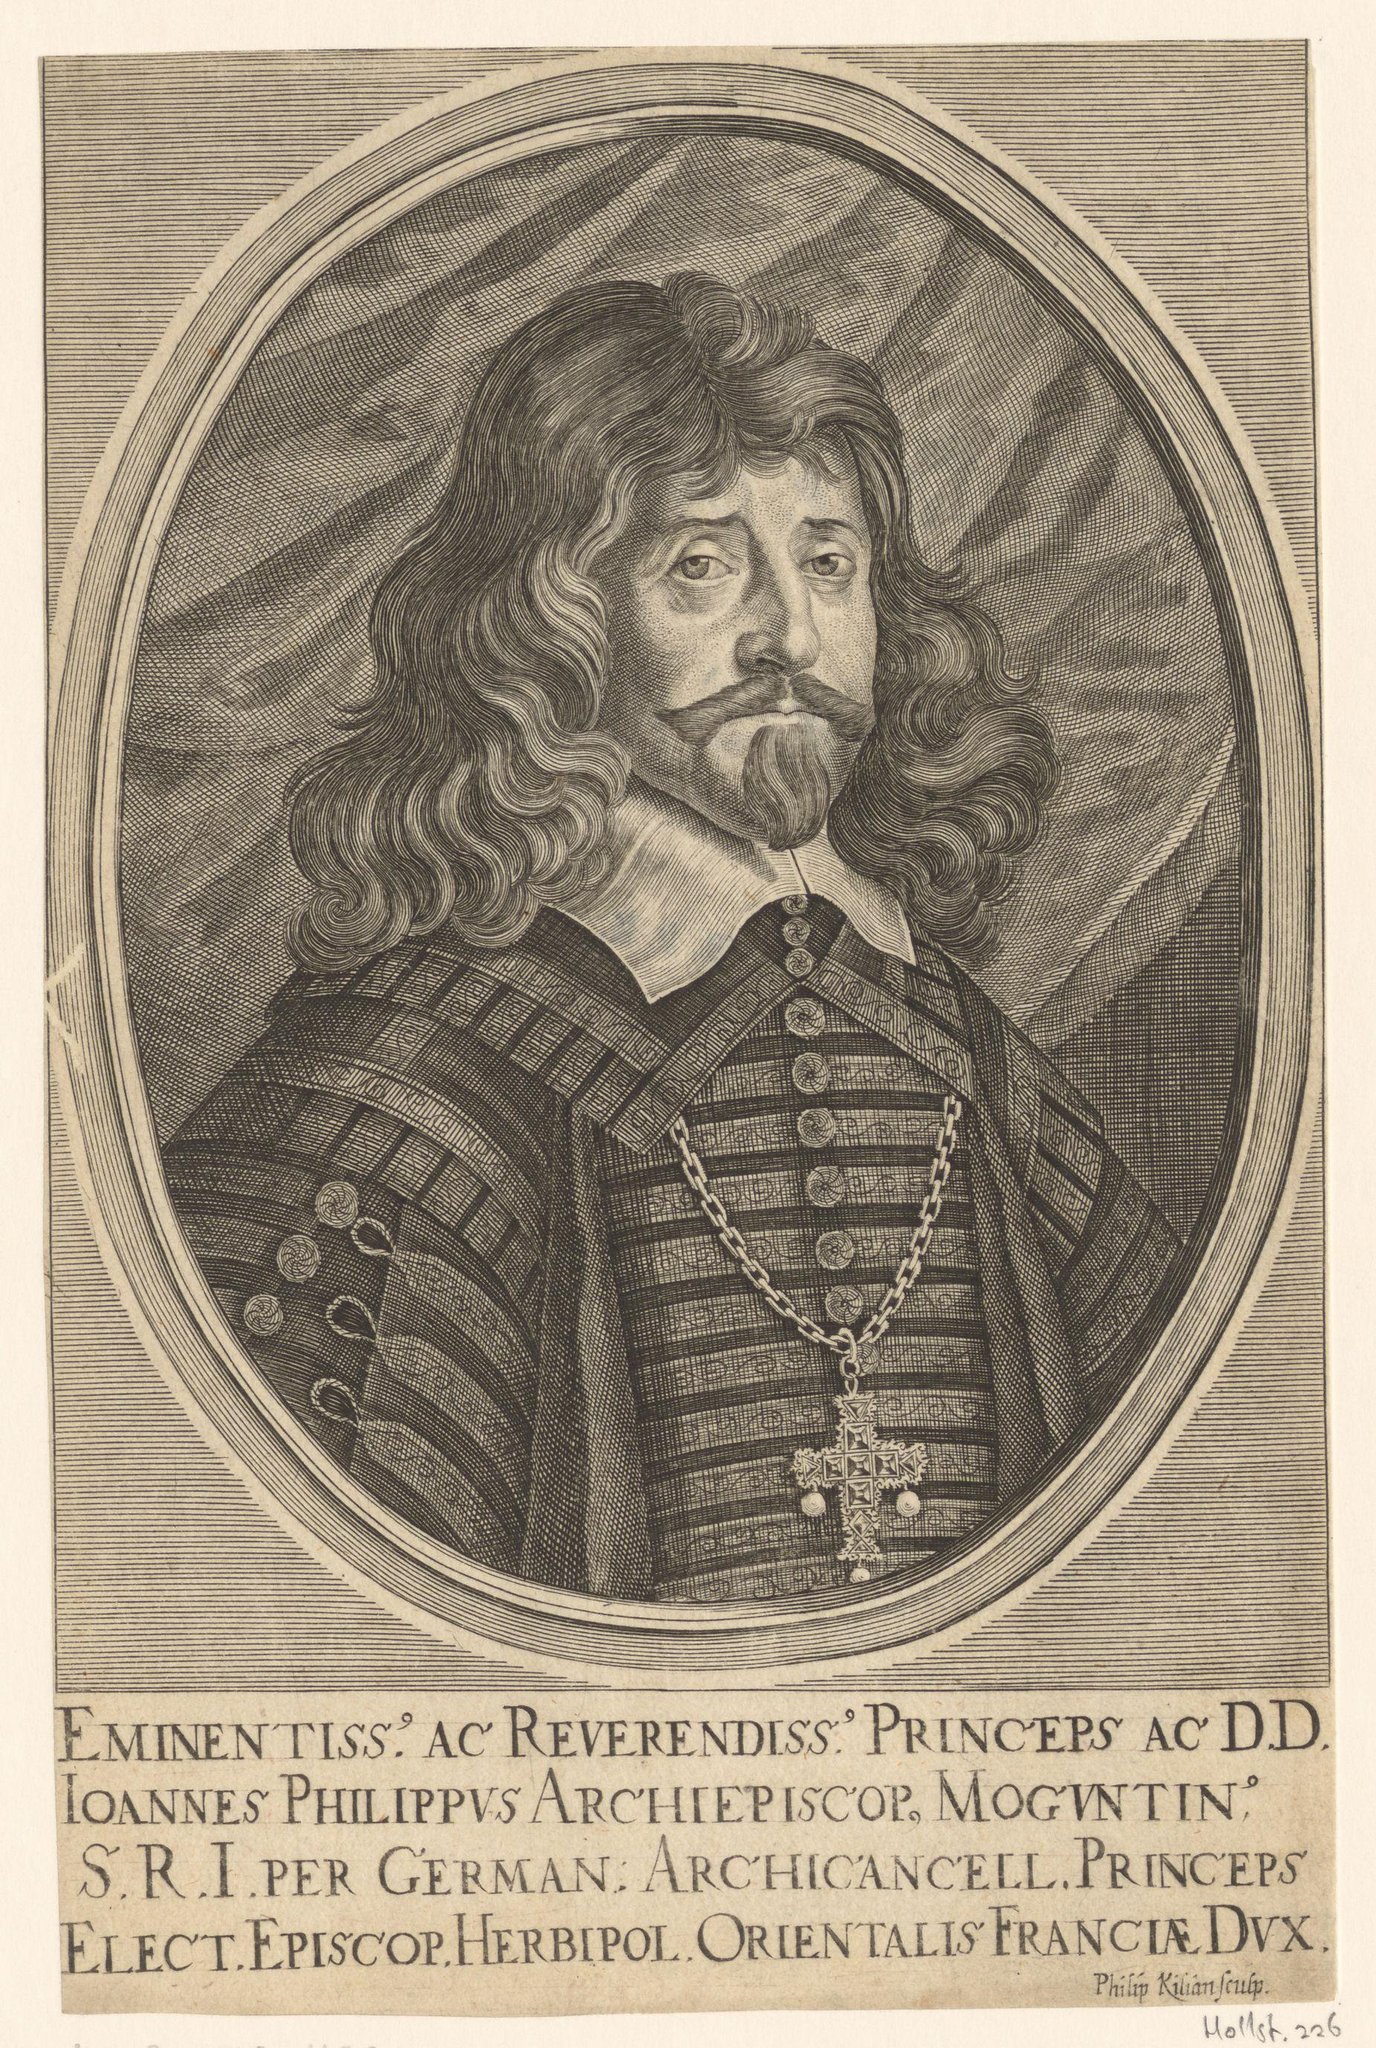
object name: print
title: Portret van Johann Philipp von Schönborn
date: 1638-1693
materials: paper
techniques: engraving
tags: archbishop, bishop, etc. (roman catholic), historical persons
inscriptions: collector's mark: Lugt 2233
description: Tekst in het Latijn in de omlijsting en in de ondermarge.